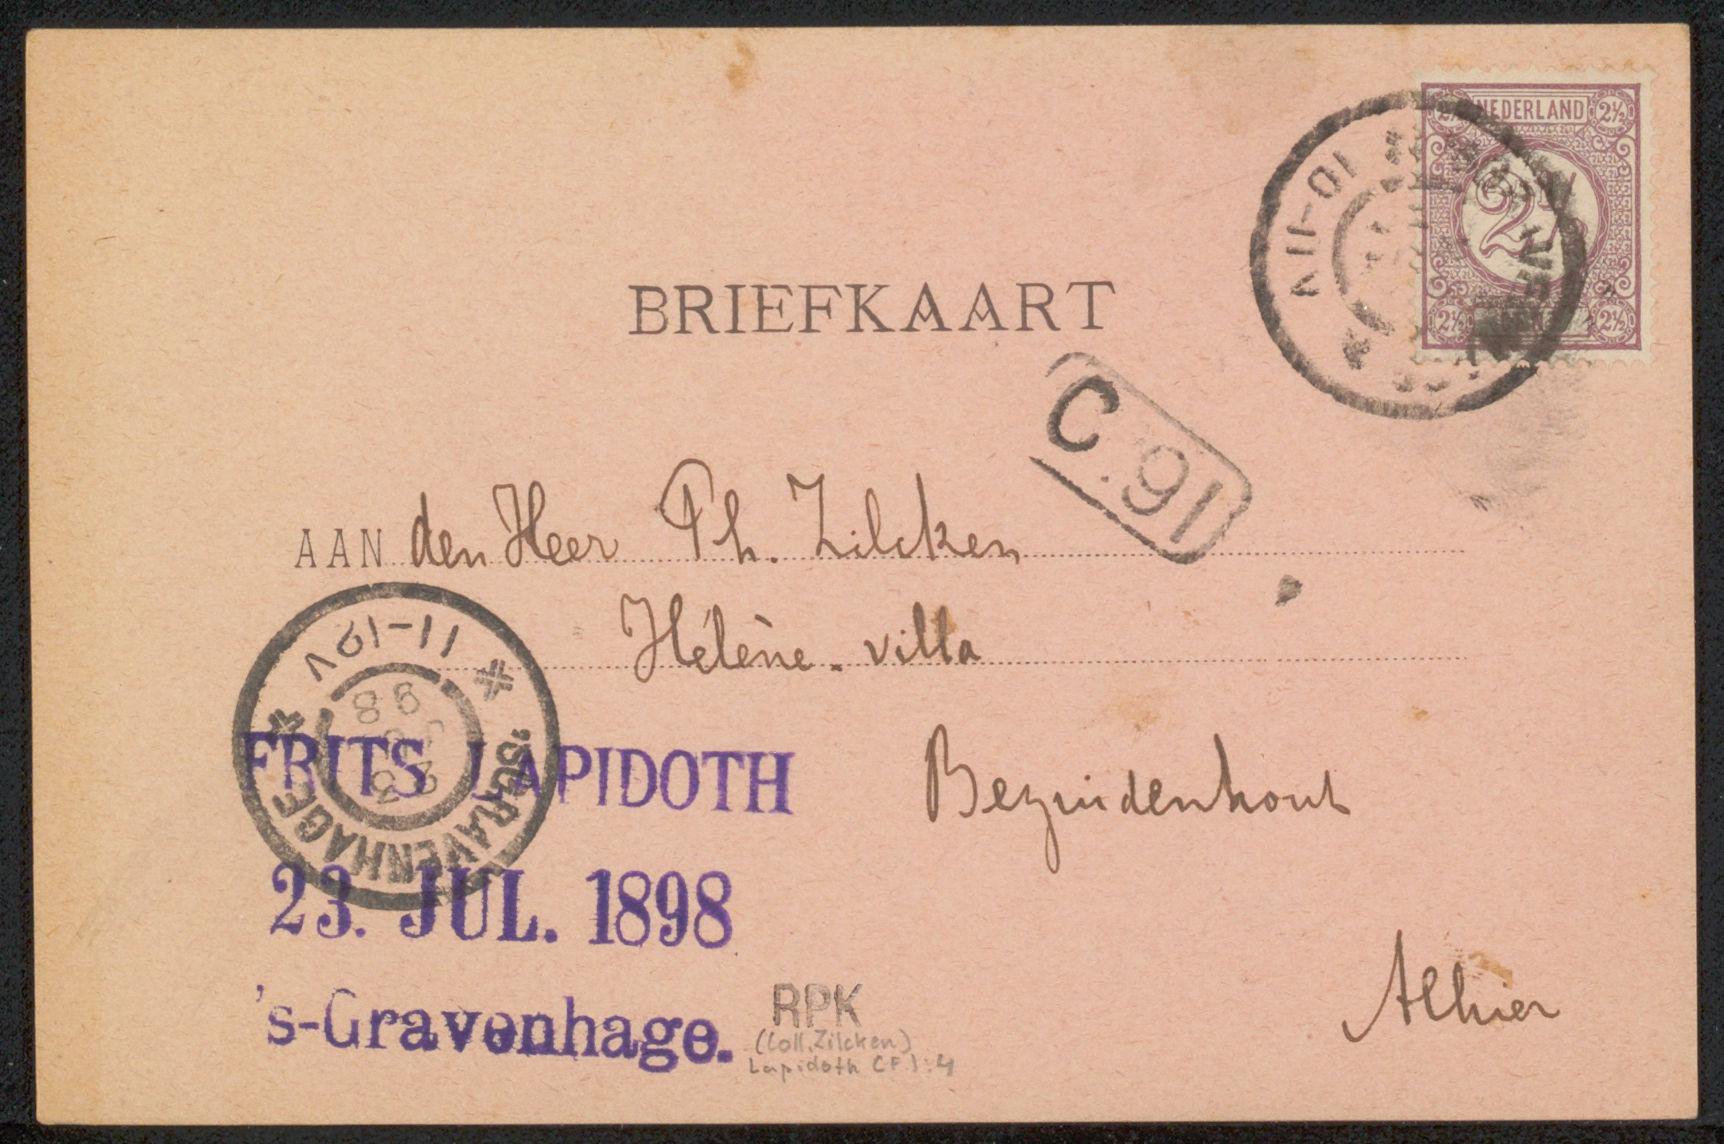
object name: postcard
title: Briefkaart aan Philip Zilcken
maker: frits lapidoth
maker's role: schrijver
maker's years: 1861-1932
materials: cardboard, ink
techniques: pen, writing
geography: the hague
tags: the hague, painter, philip zilcken, exhibition ~ art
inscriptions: date: ‘FRITS LAPIDOTH/ 23. JUL. 1898/ 's-Gravenhage’, collector's mark: ‘RPK’